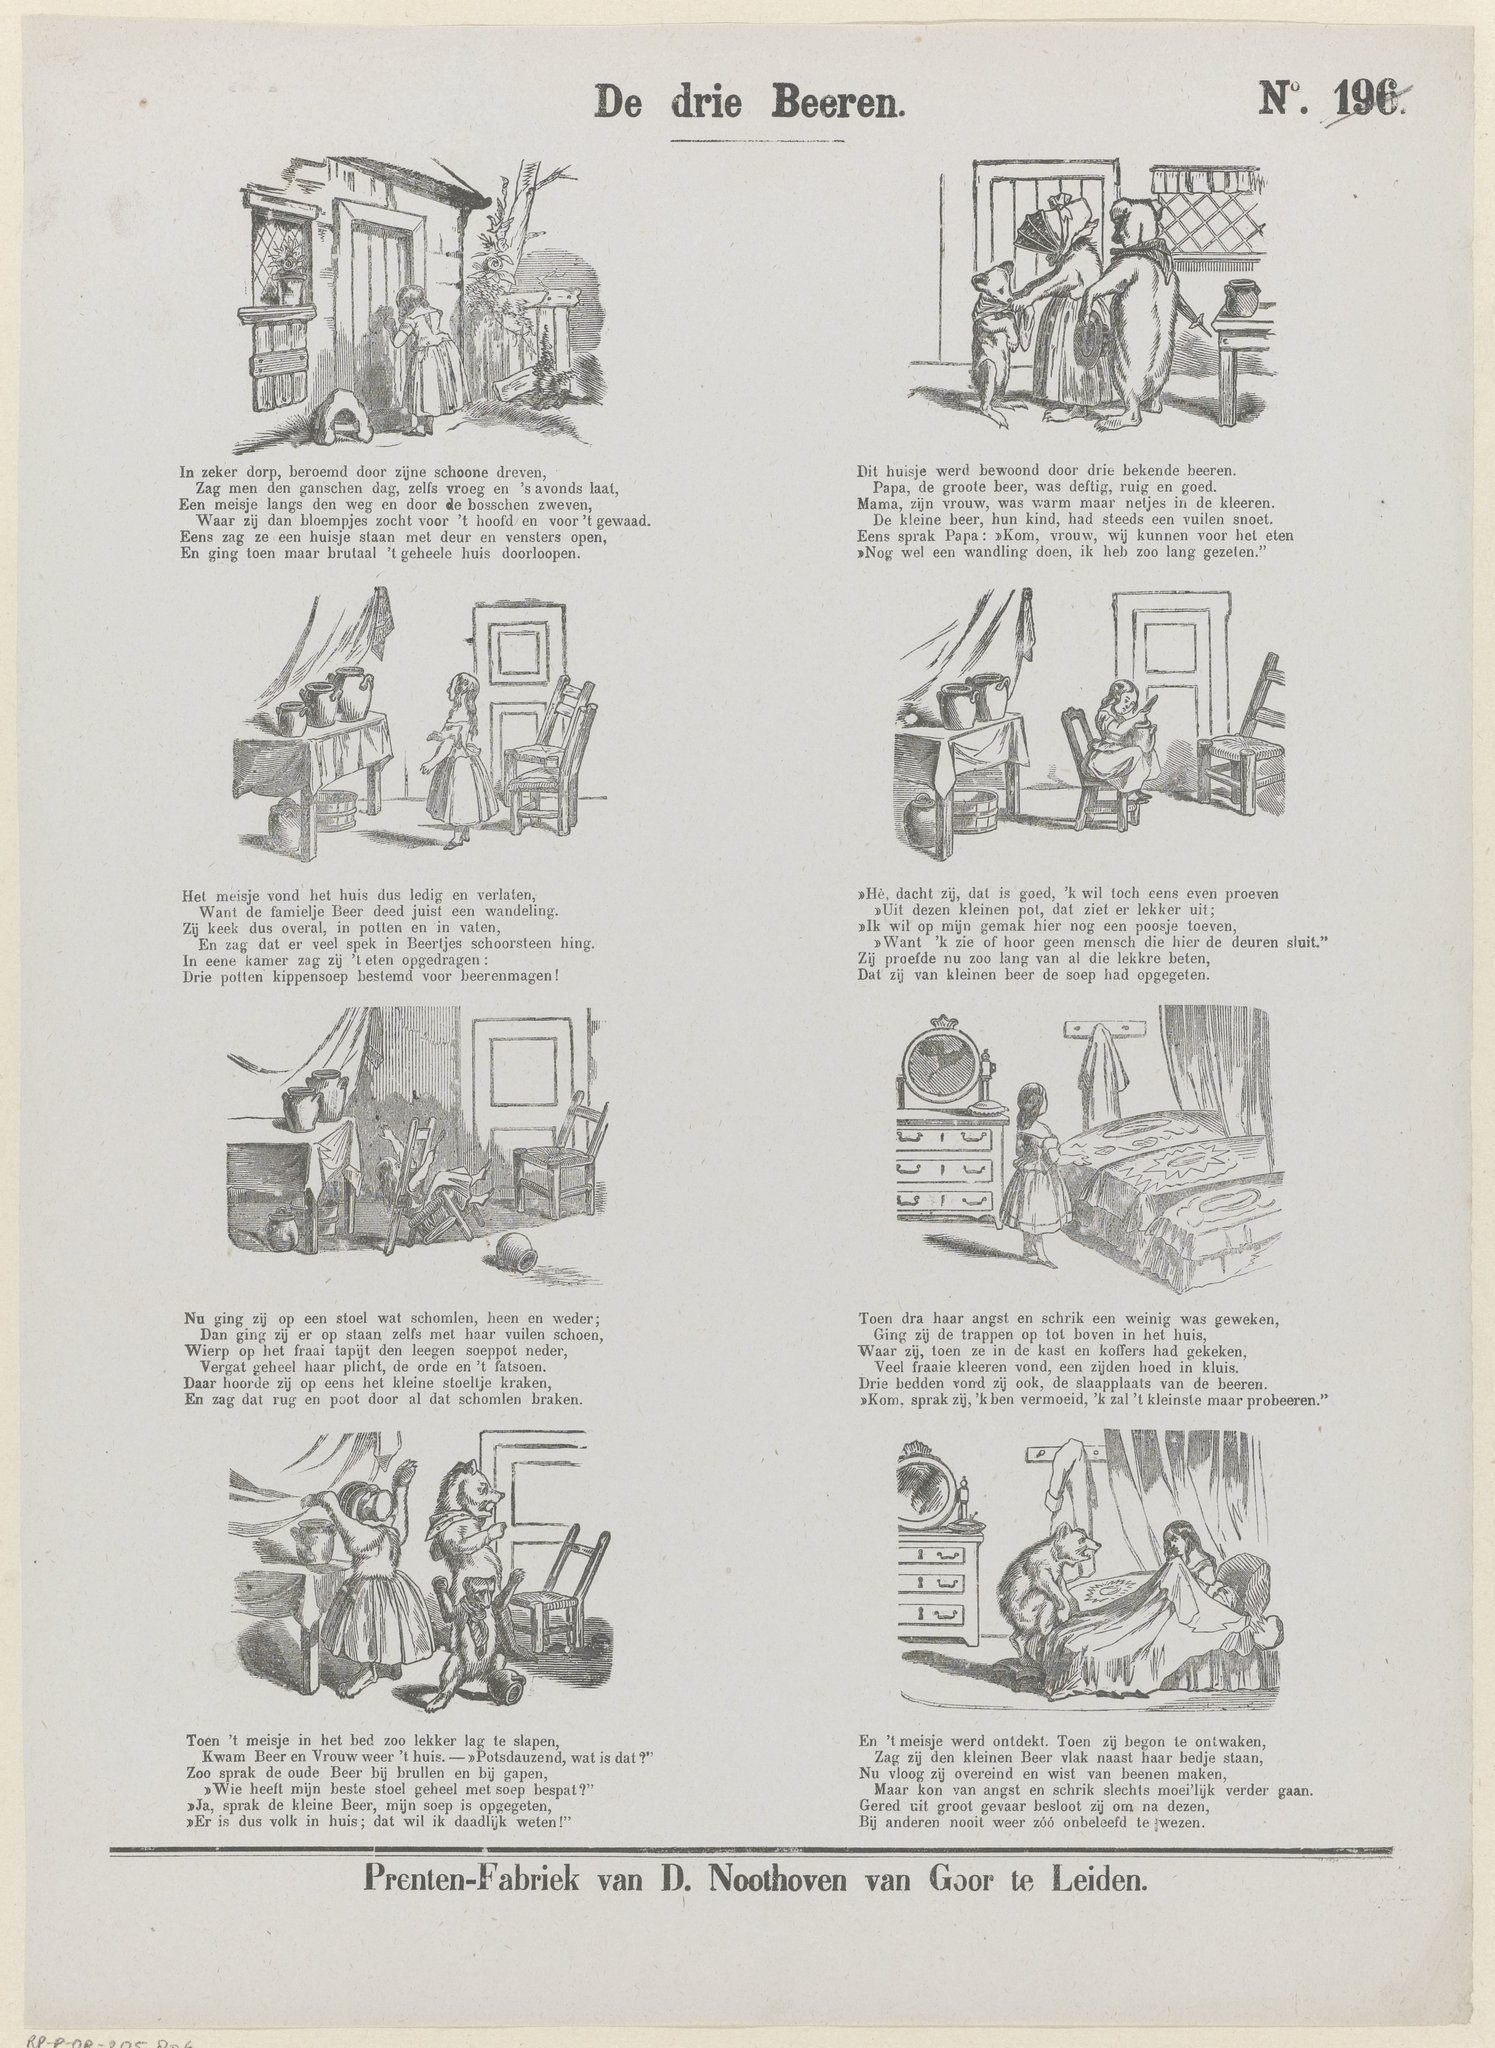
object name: print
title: De drie beren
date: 1850-1881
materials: paper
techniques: letterpress printing, engraving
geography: netherlands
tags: animals acting as human beings, beasts of prey, predatory animals: bear, tales and fairy tales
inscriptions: collector's mark: Lugt 2760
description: Blad met 8 voorstellingen uit het sprookje van Goudlokje en de drie beren. Onder elke voorstelling een zesregelig vers. Genummerd rechtsboven: No. 196.